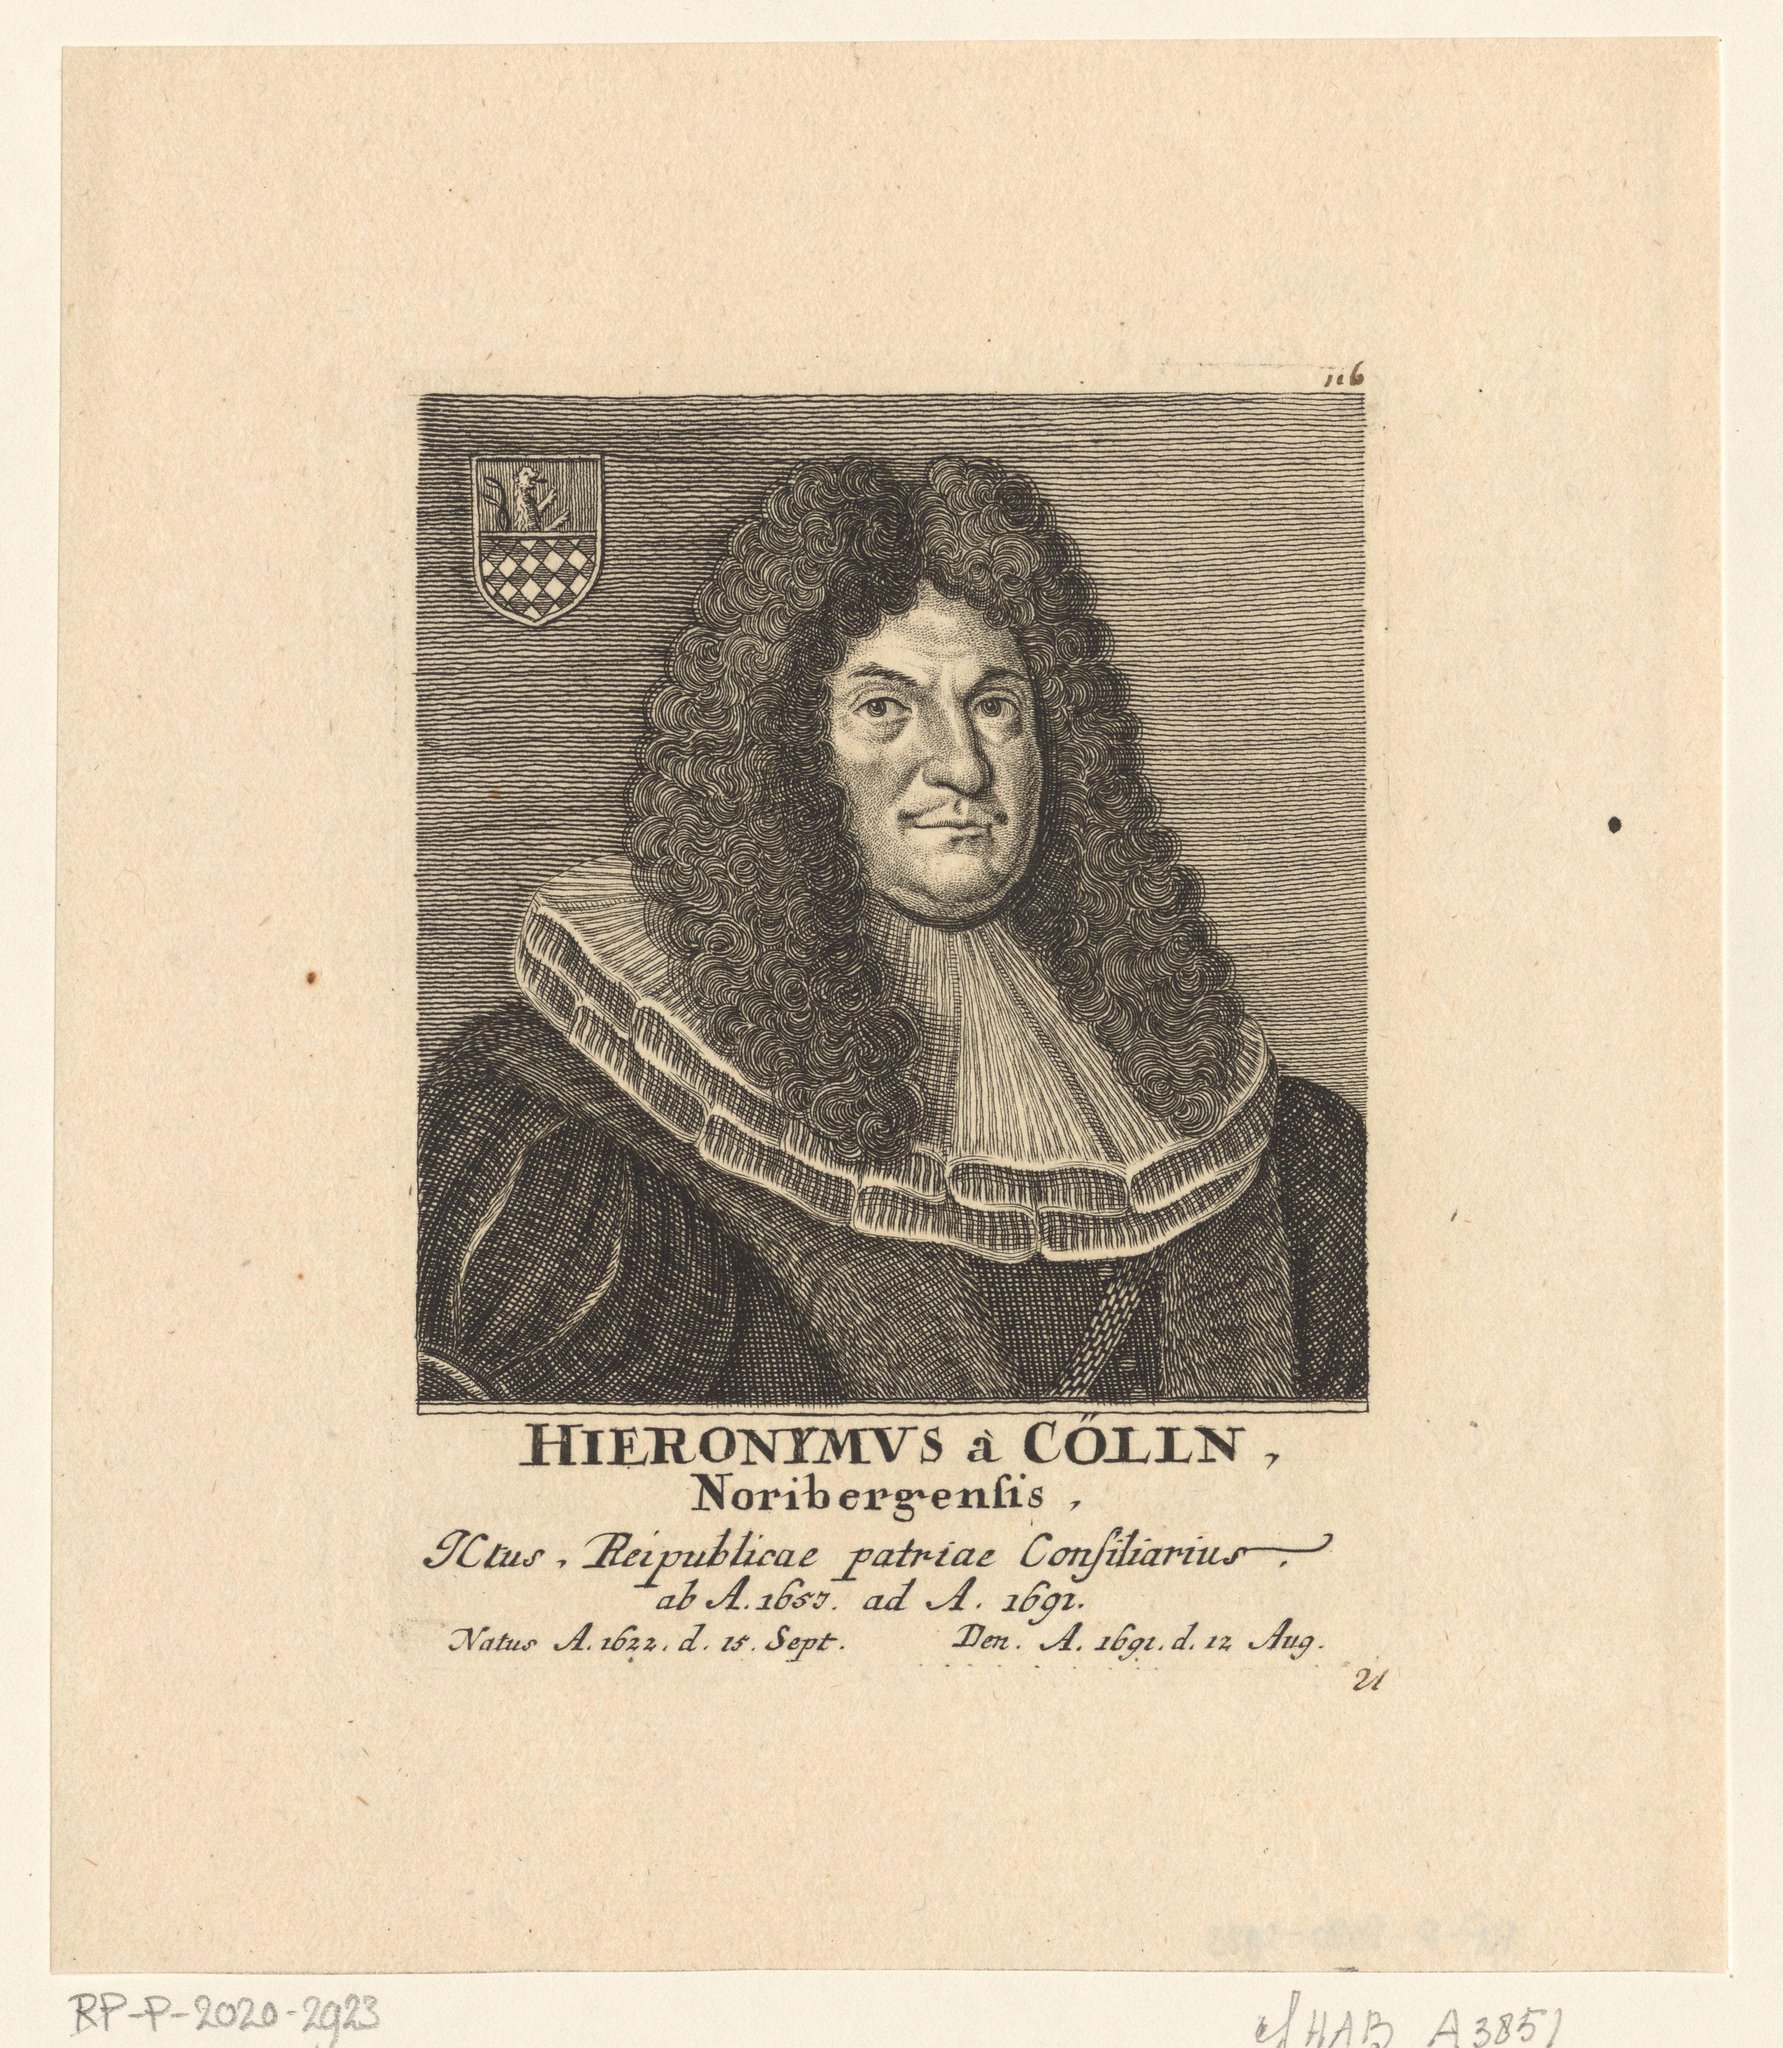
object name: print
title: Portret van Hieronymus von Cölln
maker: Anonymous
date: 1725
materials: paper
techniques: engraving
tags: theologian, historical persons, armorial bearing, heraldry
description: Prent mogelijk uit: Rothscholtz, Friedrich. Icones virorum omnium ordinum eruditione: omnique item genere et varietate artium de republica litteraria et speciatim de Academiis et Gymnasiis (...). Neurenberg: erven Johann Daniel Tauber, 1725, dl. 1.